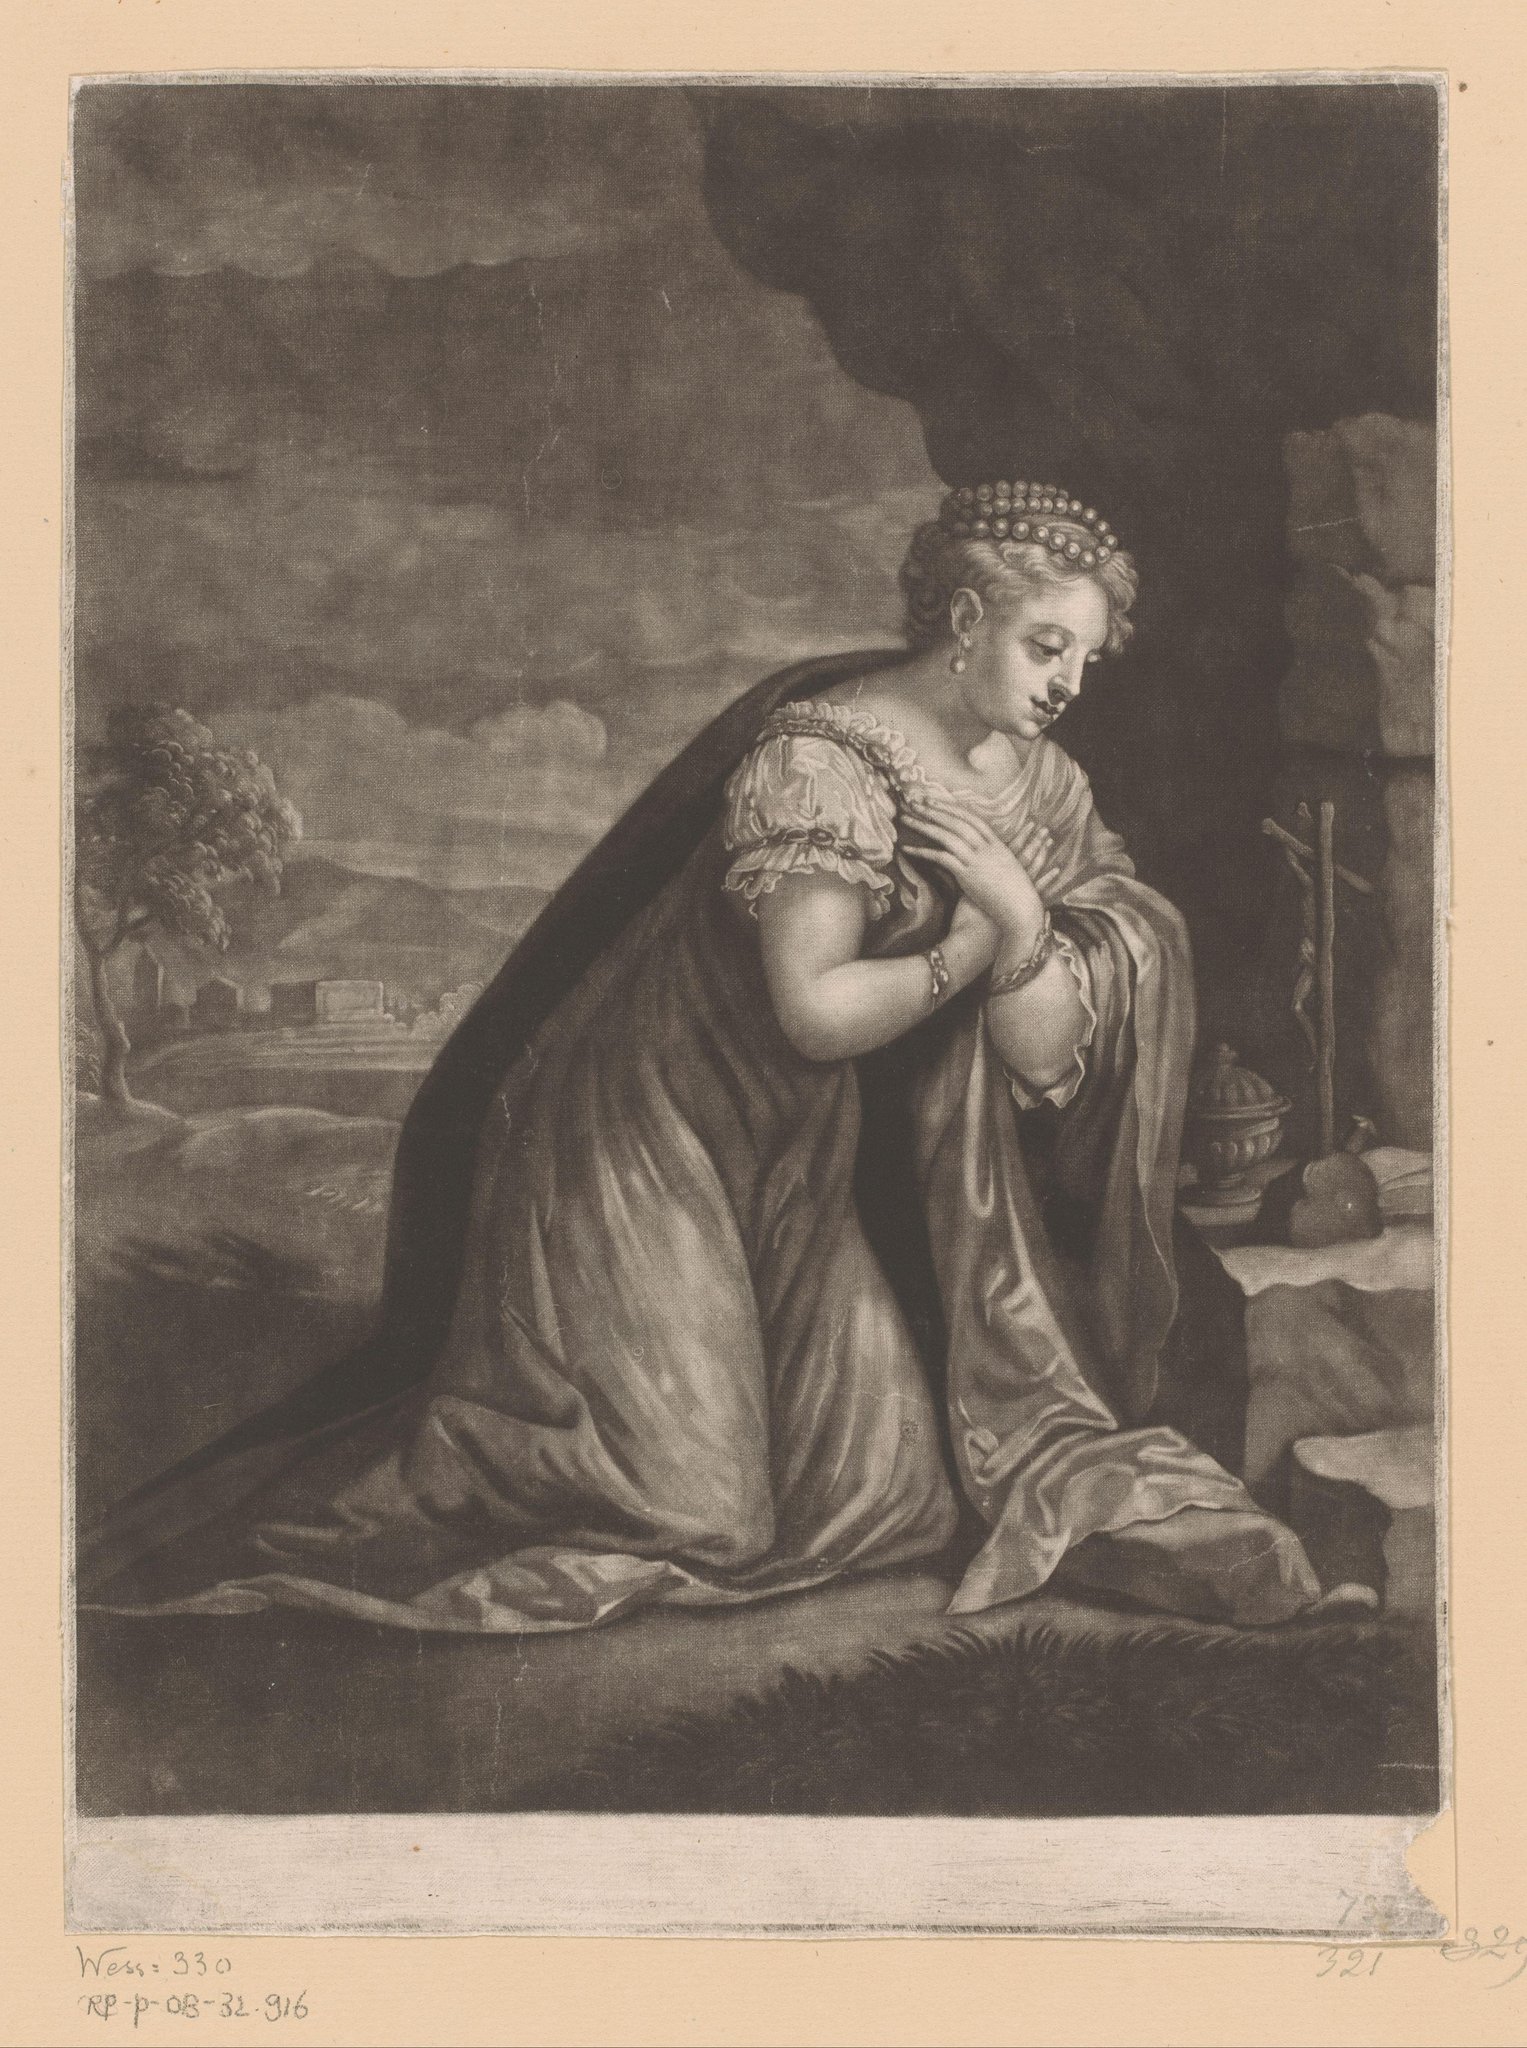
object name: print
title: H. Maria Magdalena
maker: john smith (prentmaker/ uitgever)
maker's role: print maker, publisher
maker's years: 1652-1743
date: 1662-1742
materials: paper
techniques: mezzotint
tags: the penitent harlot mary magdalene; possible attributes: book (or scroll), crown, crown of thorns, crucifix, jar of ointment, mirror, musical instrument, palm-branch, rosary, scourge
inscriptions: collector's mark: Lugt 240